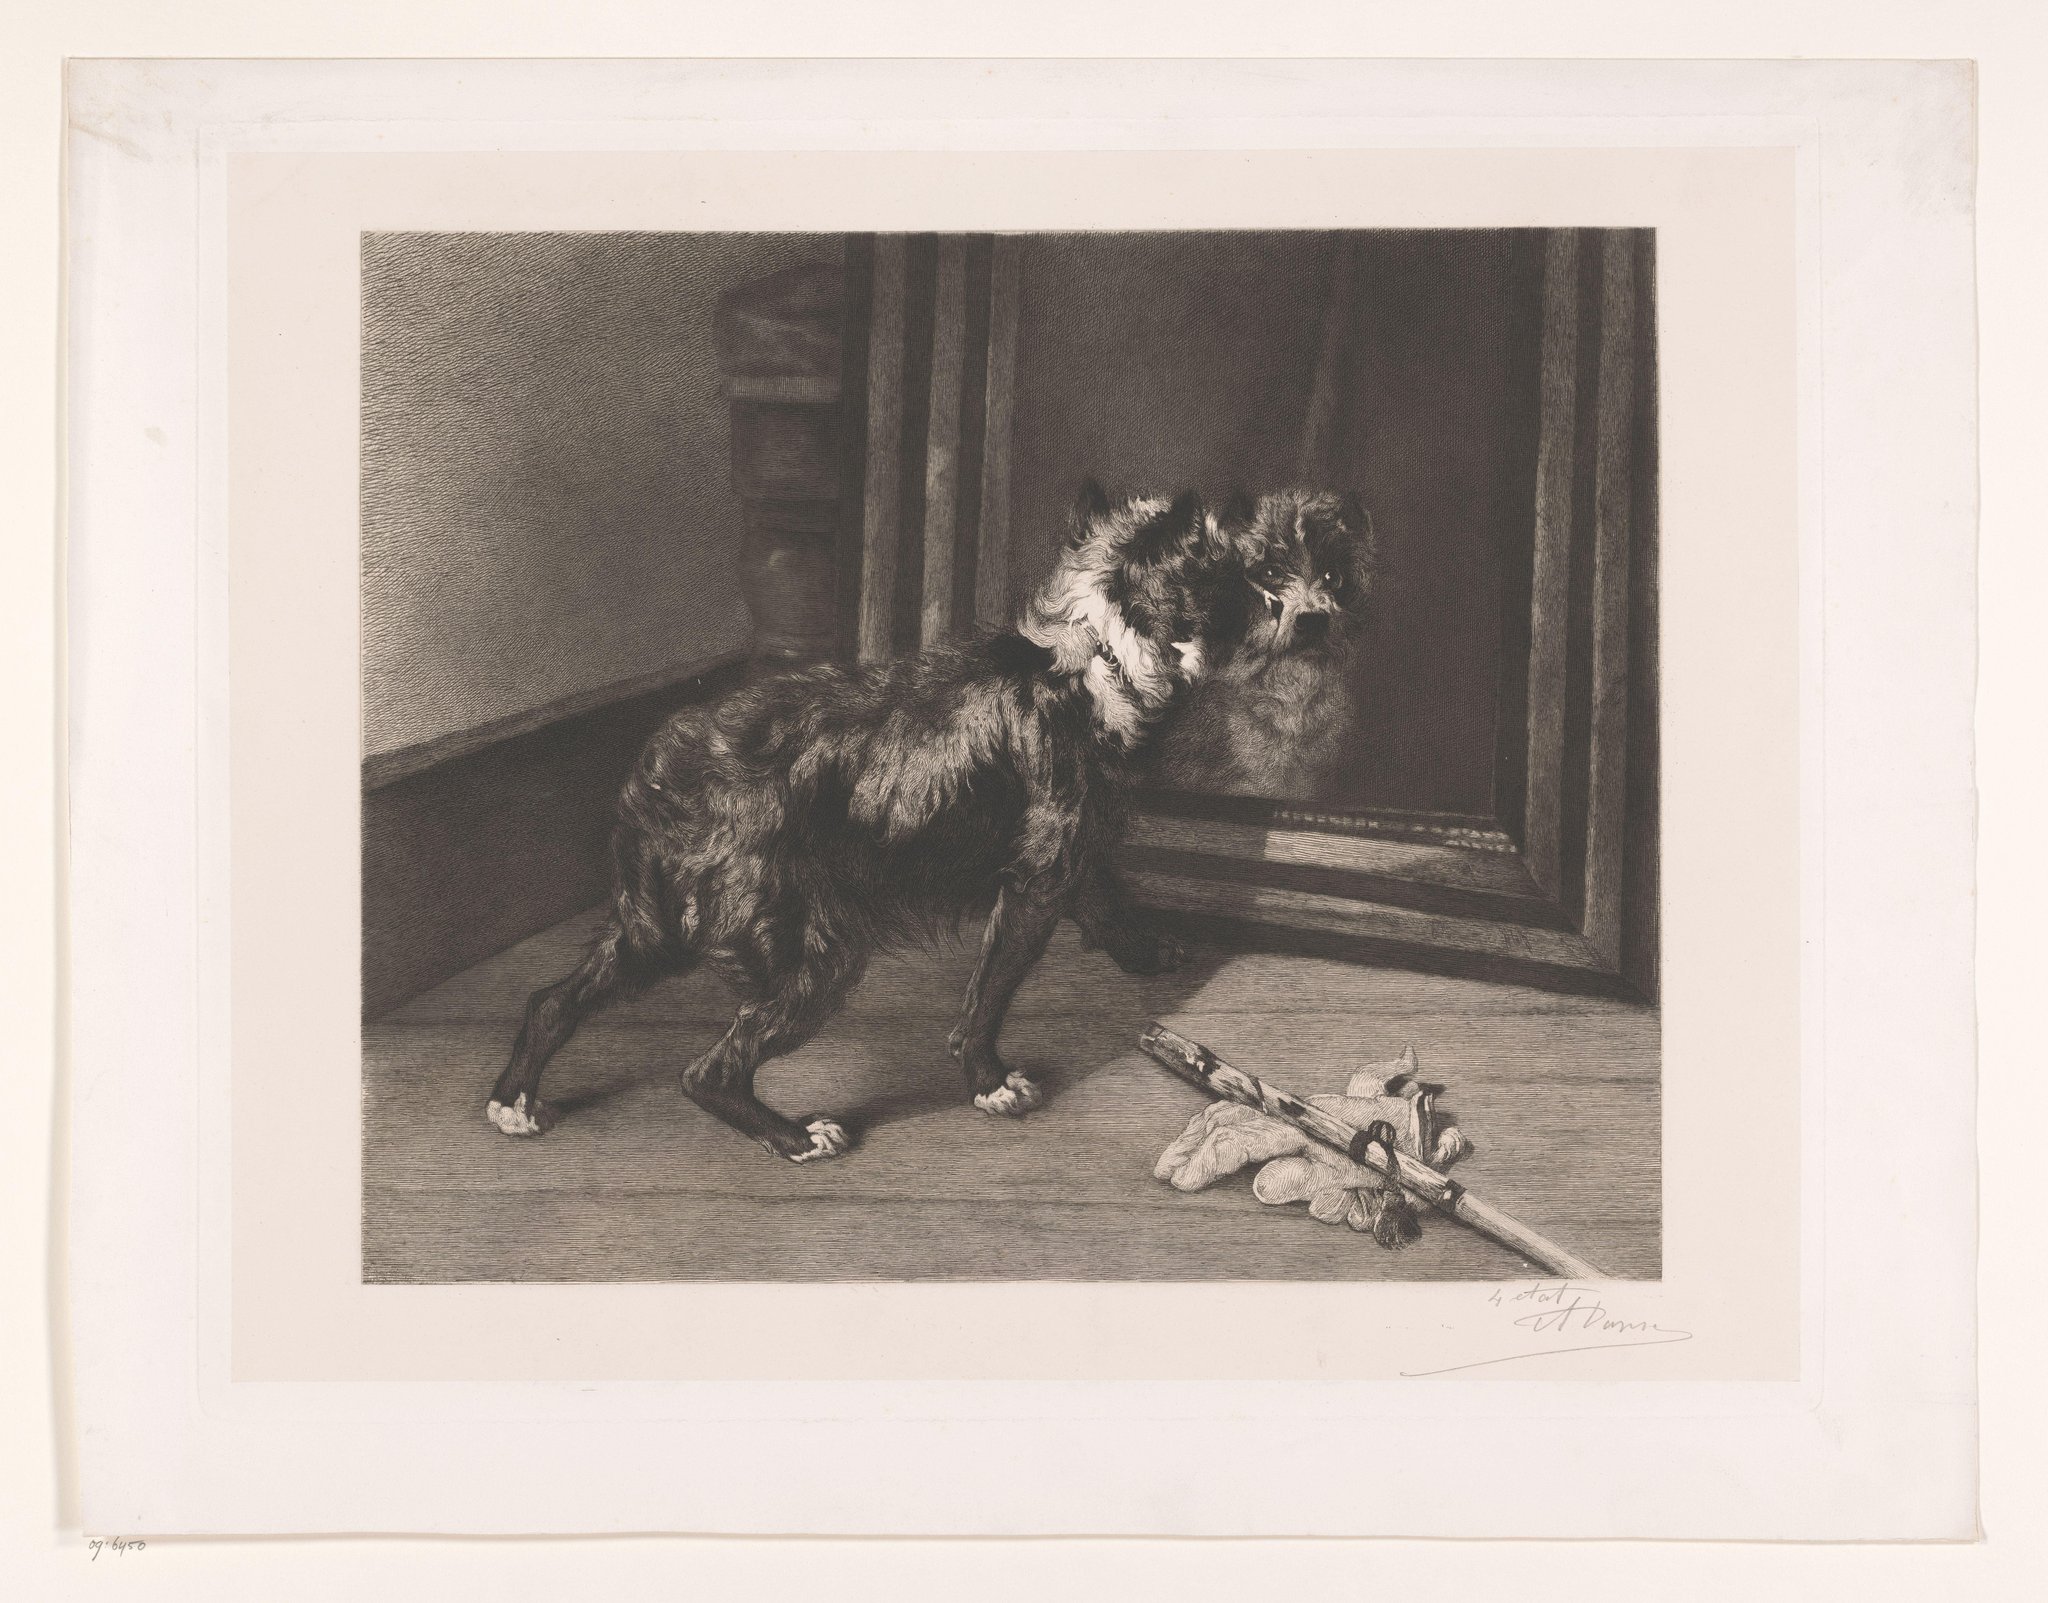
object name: print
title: Hond voor een spiegel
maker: auguste danse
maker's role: print maker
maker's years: 1829-1929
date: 1891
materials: paper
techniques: etching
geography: belgium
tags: mirror, dog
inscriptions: annotation: ‘4 etat’, collector's mark: Lugt 2228